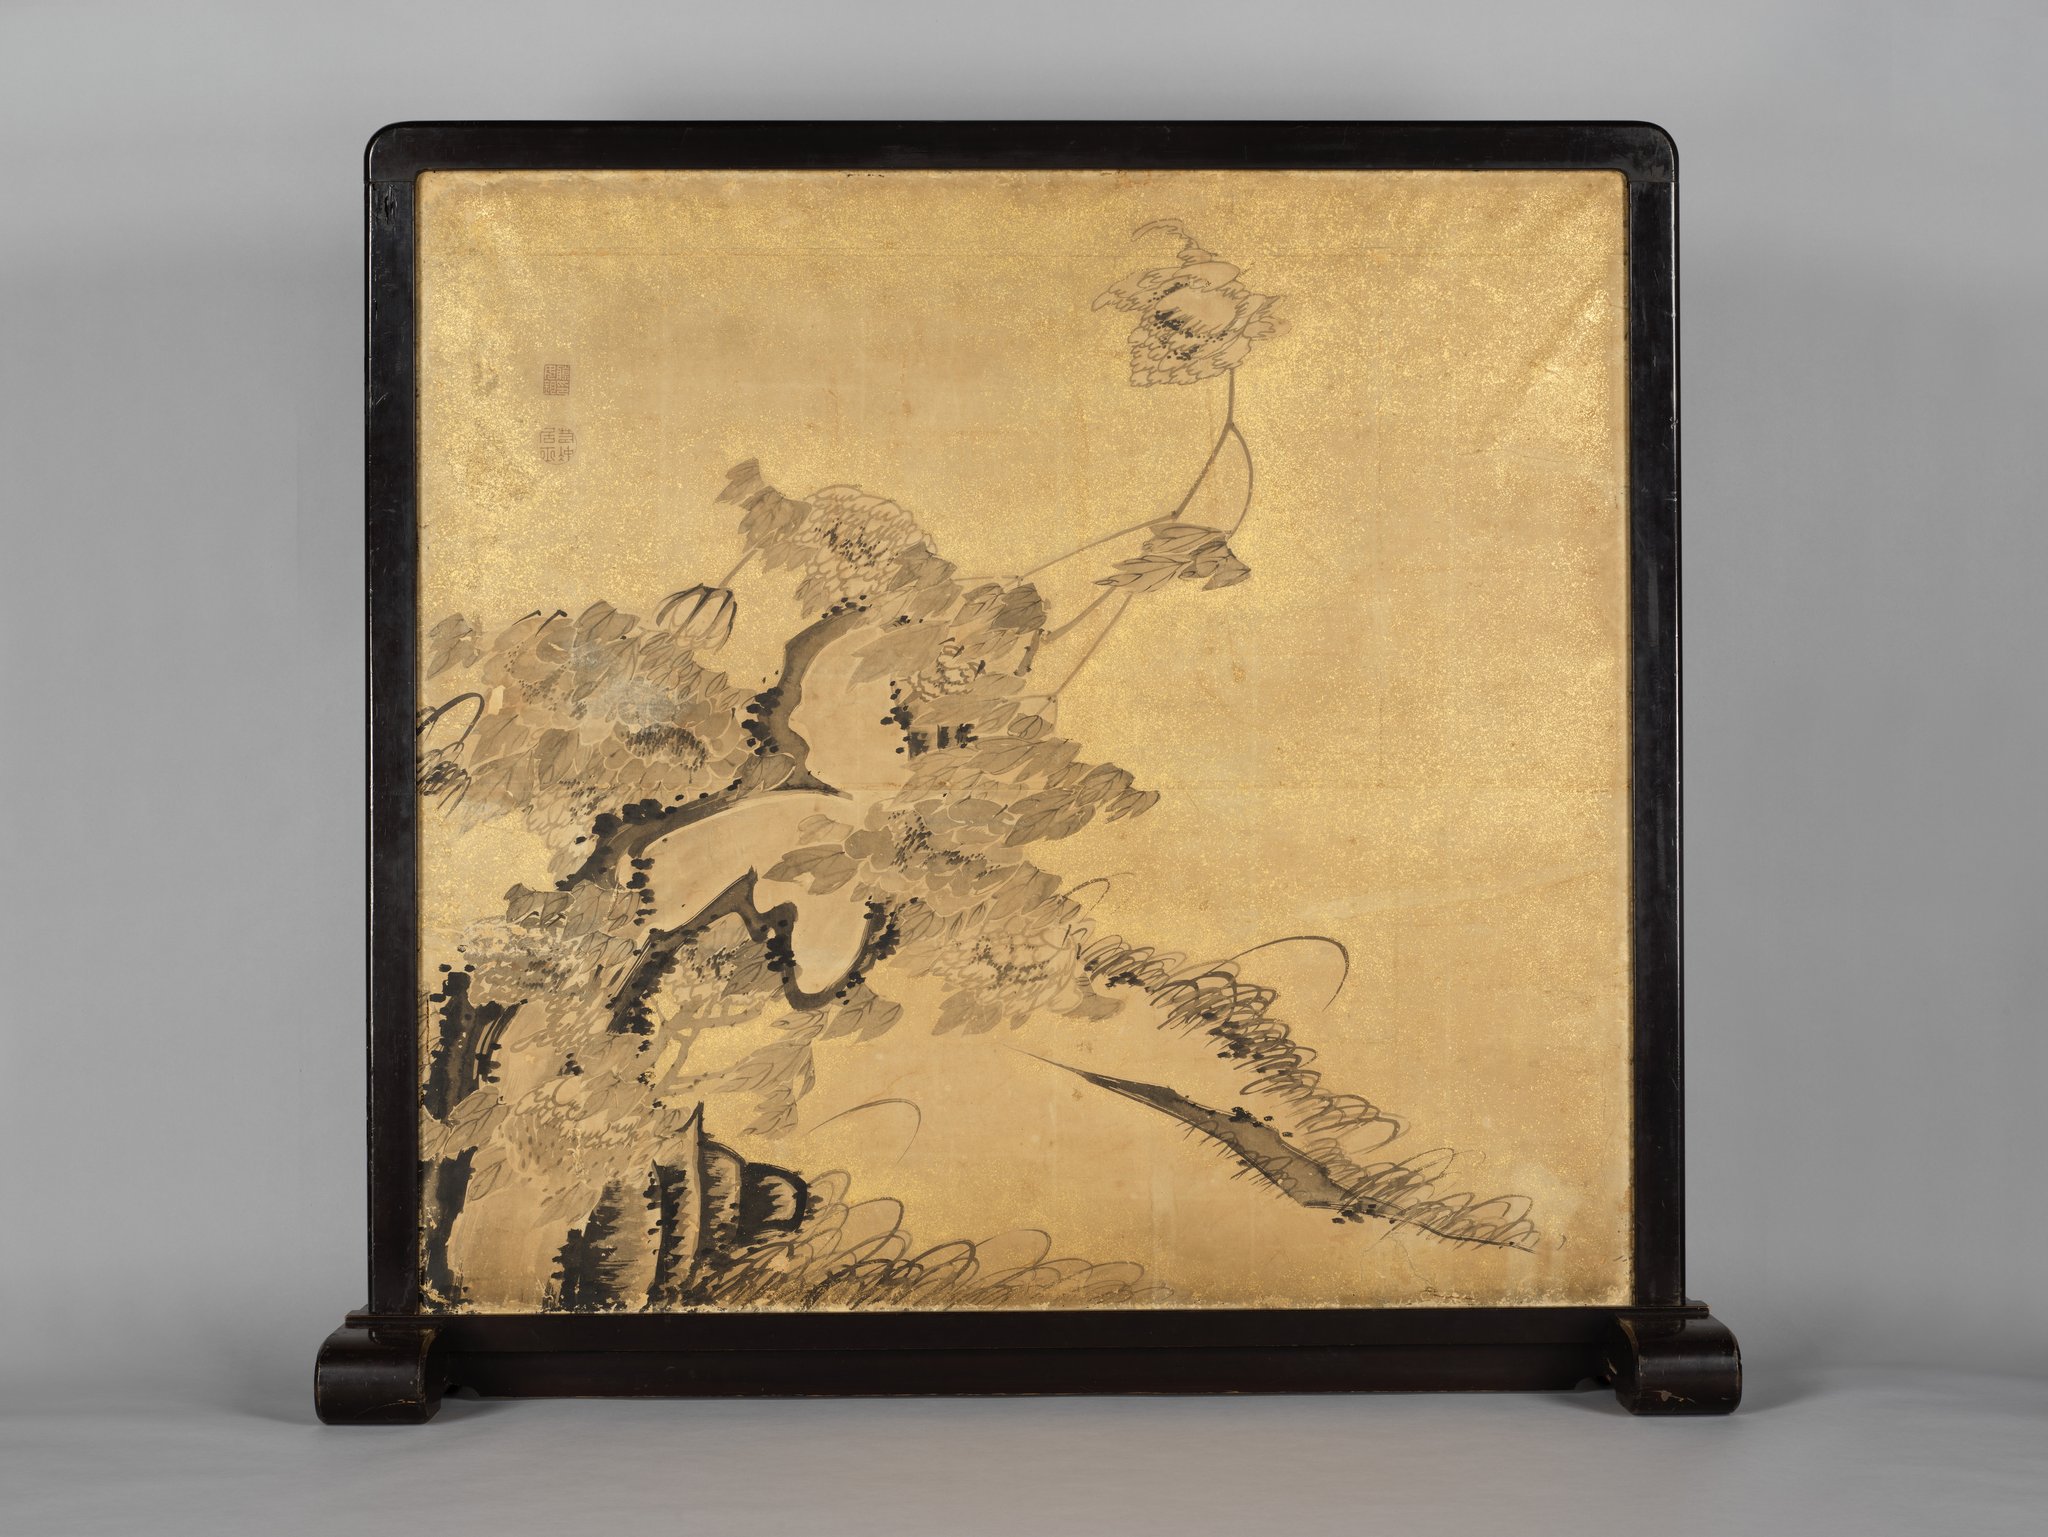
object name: screen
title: Crabs and Peonies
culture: japanese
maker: itō jakuchū 伊藤若冲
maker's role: artist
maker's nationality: japanese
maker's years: 1716-1800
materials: gold, ink, paper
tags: crabs,peonies